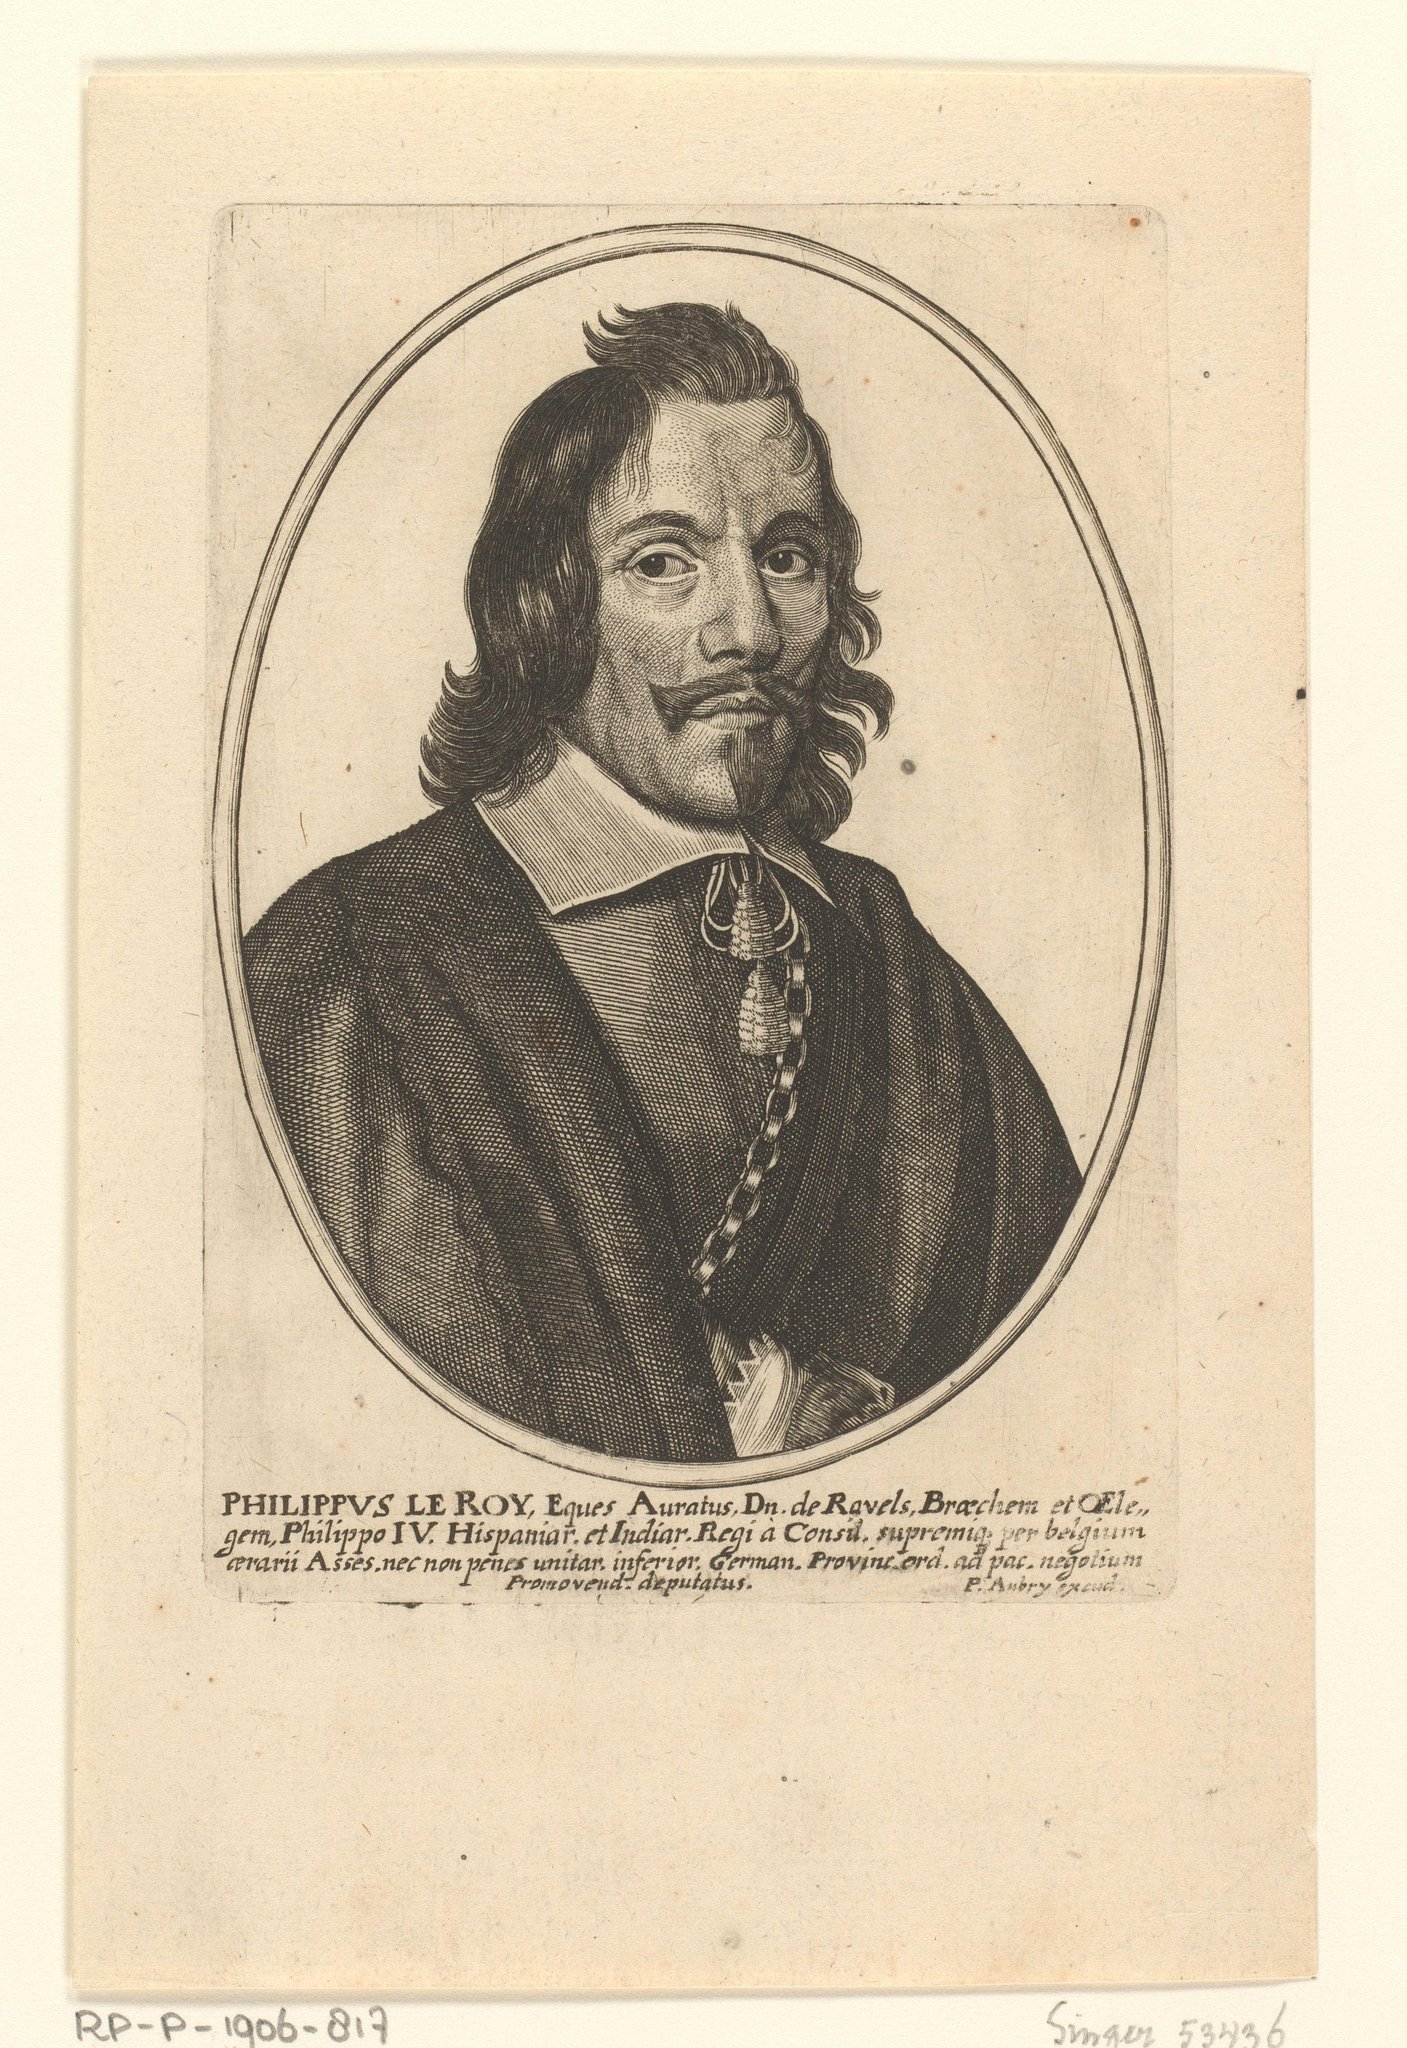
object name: print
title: Portret van Philippe Le Roy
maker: Anonymous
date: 1636-1686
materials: paper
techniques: engraving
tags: historical persons, diplomacy, diplomat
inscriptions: collector's mark: Lugt 2228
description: Met vierregelig onderschrift in het Latijn.